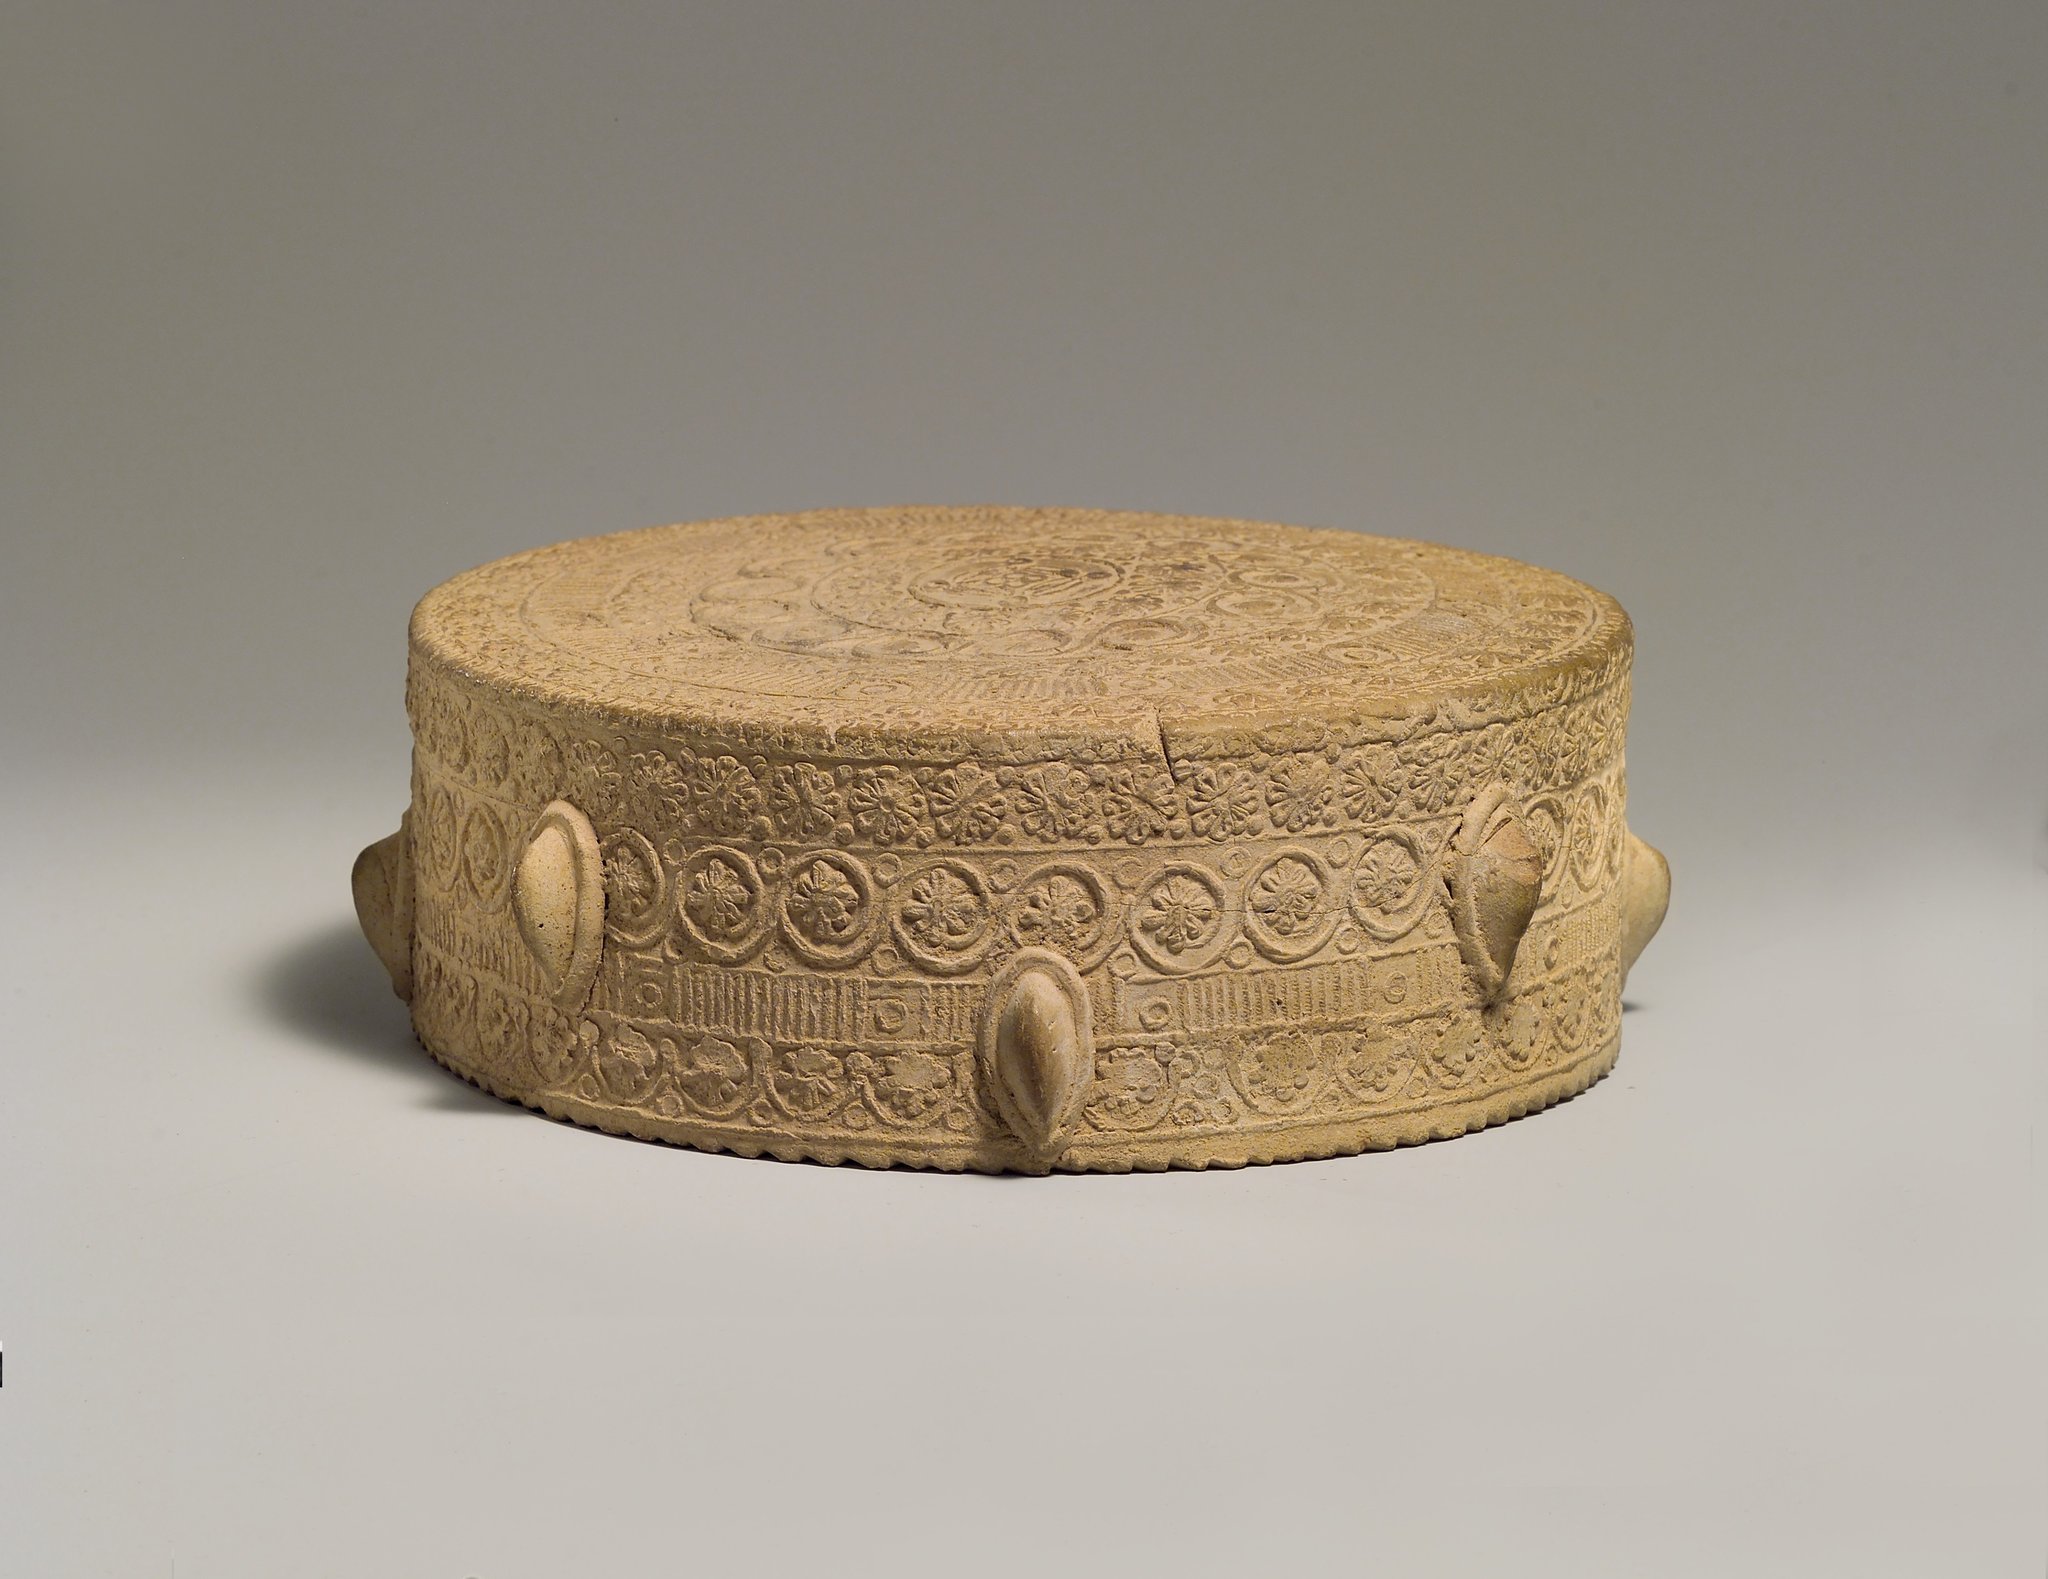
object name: dish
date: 661-750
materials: earthenware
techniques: molding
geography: iran